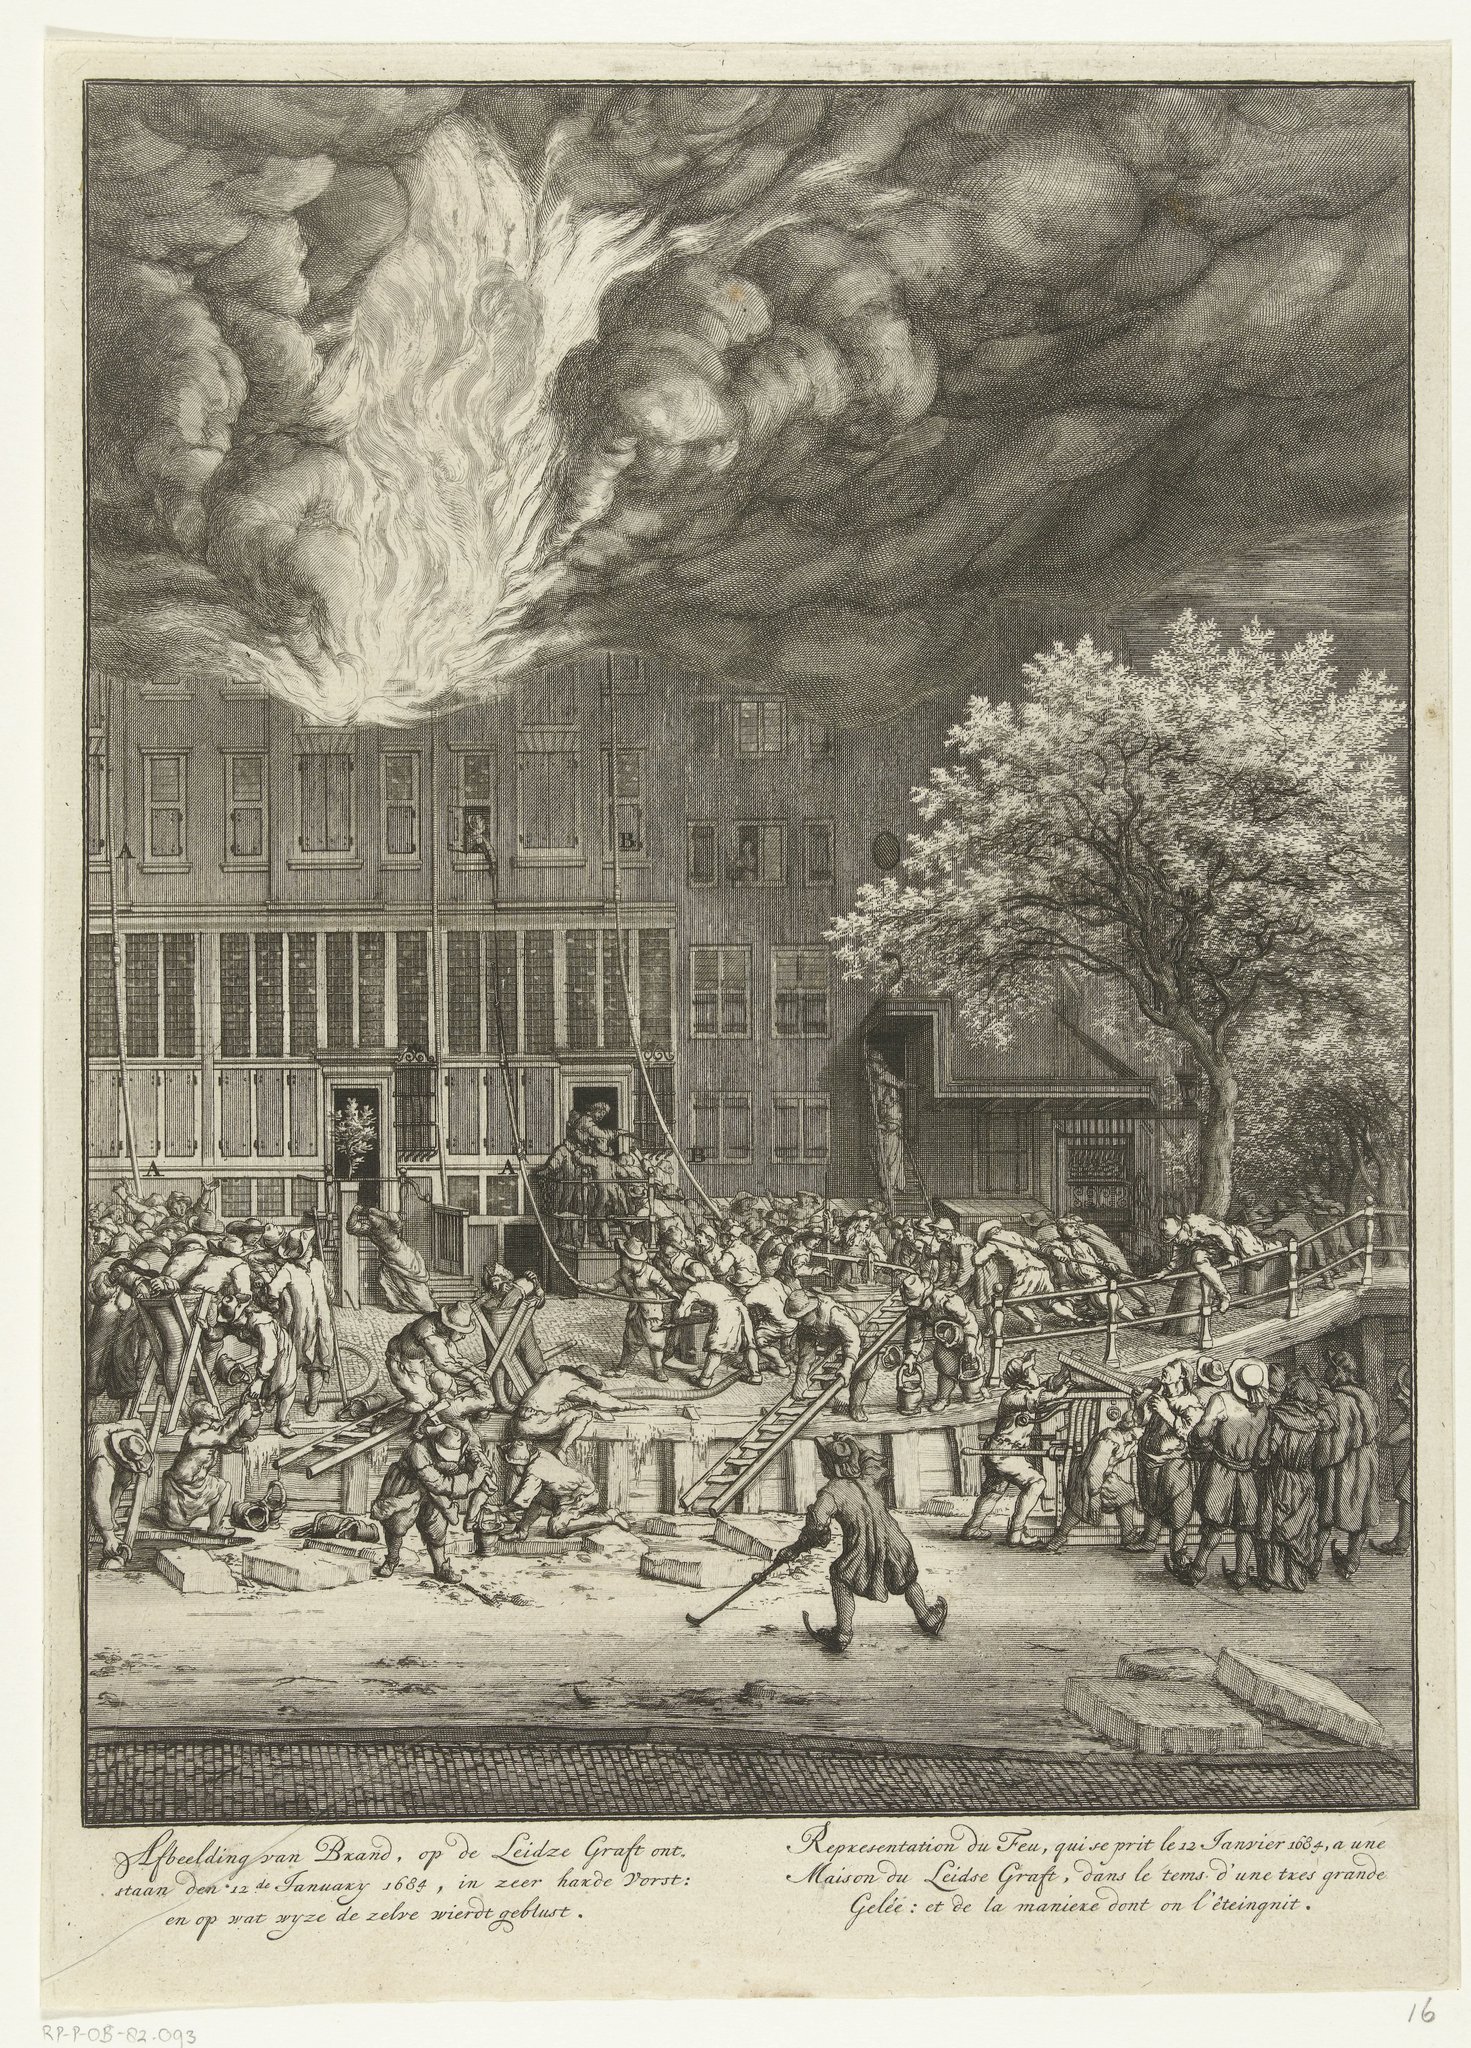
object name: print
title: Brand in een huis op de Leidsegracht, 1684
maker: jan van der heyden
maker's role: draughtsman, painter, print maker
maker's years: 1637-1712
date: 1690-1735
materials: paper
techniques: engraving, etching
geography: amsterdam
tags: painter, print maker, draughtsman, jan van der heyden, on fire, ablaze, fire-fighting, fire-extinguishing equipment, severe winters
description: Prent ook gebruikt in: Heyden, Jan van der. Beschryving der nieuwlyks uitgevonden en geoctrojeerde slang-brand-spuiten en haare wyze van brand-blussen, tegenwoordig binnen Amsterdam in gebruik zijnde (…). 1e druk. Amsterdam: Jan Rieuwertsz. (II), 1690. En in: Heyden, Jan van der. Beschryving der nieuwlyks uitgevonden en geoctrojeerde slang-brand-spuiten en haare wyze van brand-blussen, tegenwoordig binnen Amsterdam in gebruik zijnde (…). 2e druk. Amsterdam: erfgenamen Jan van der Heyden, 1735.